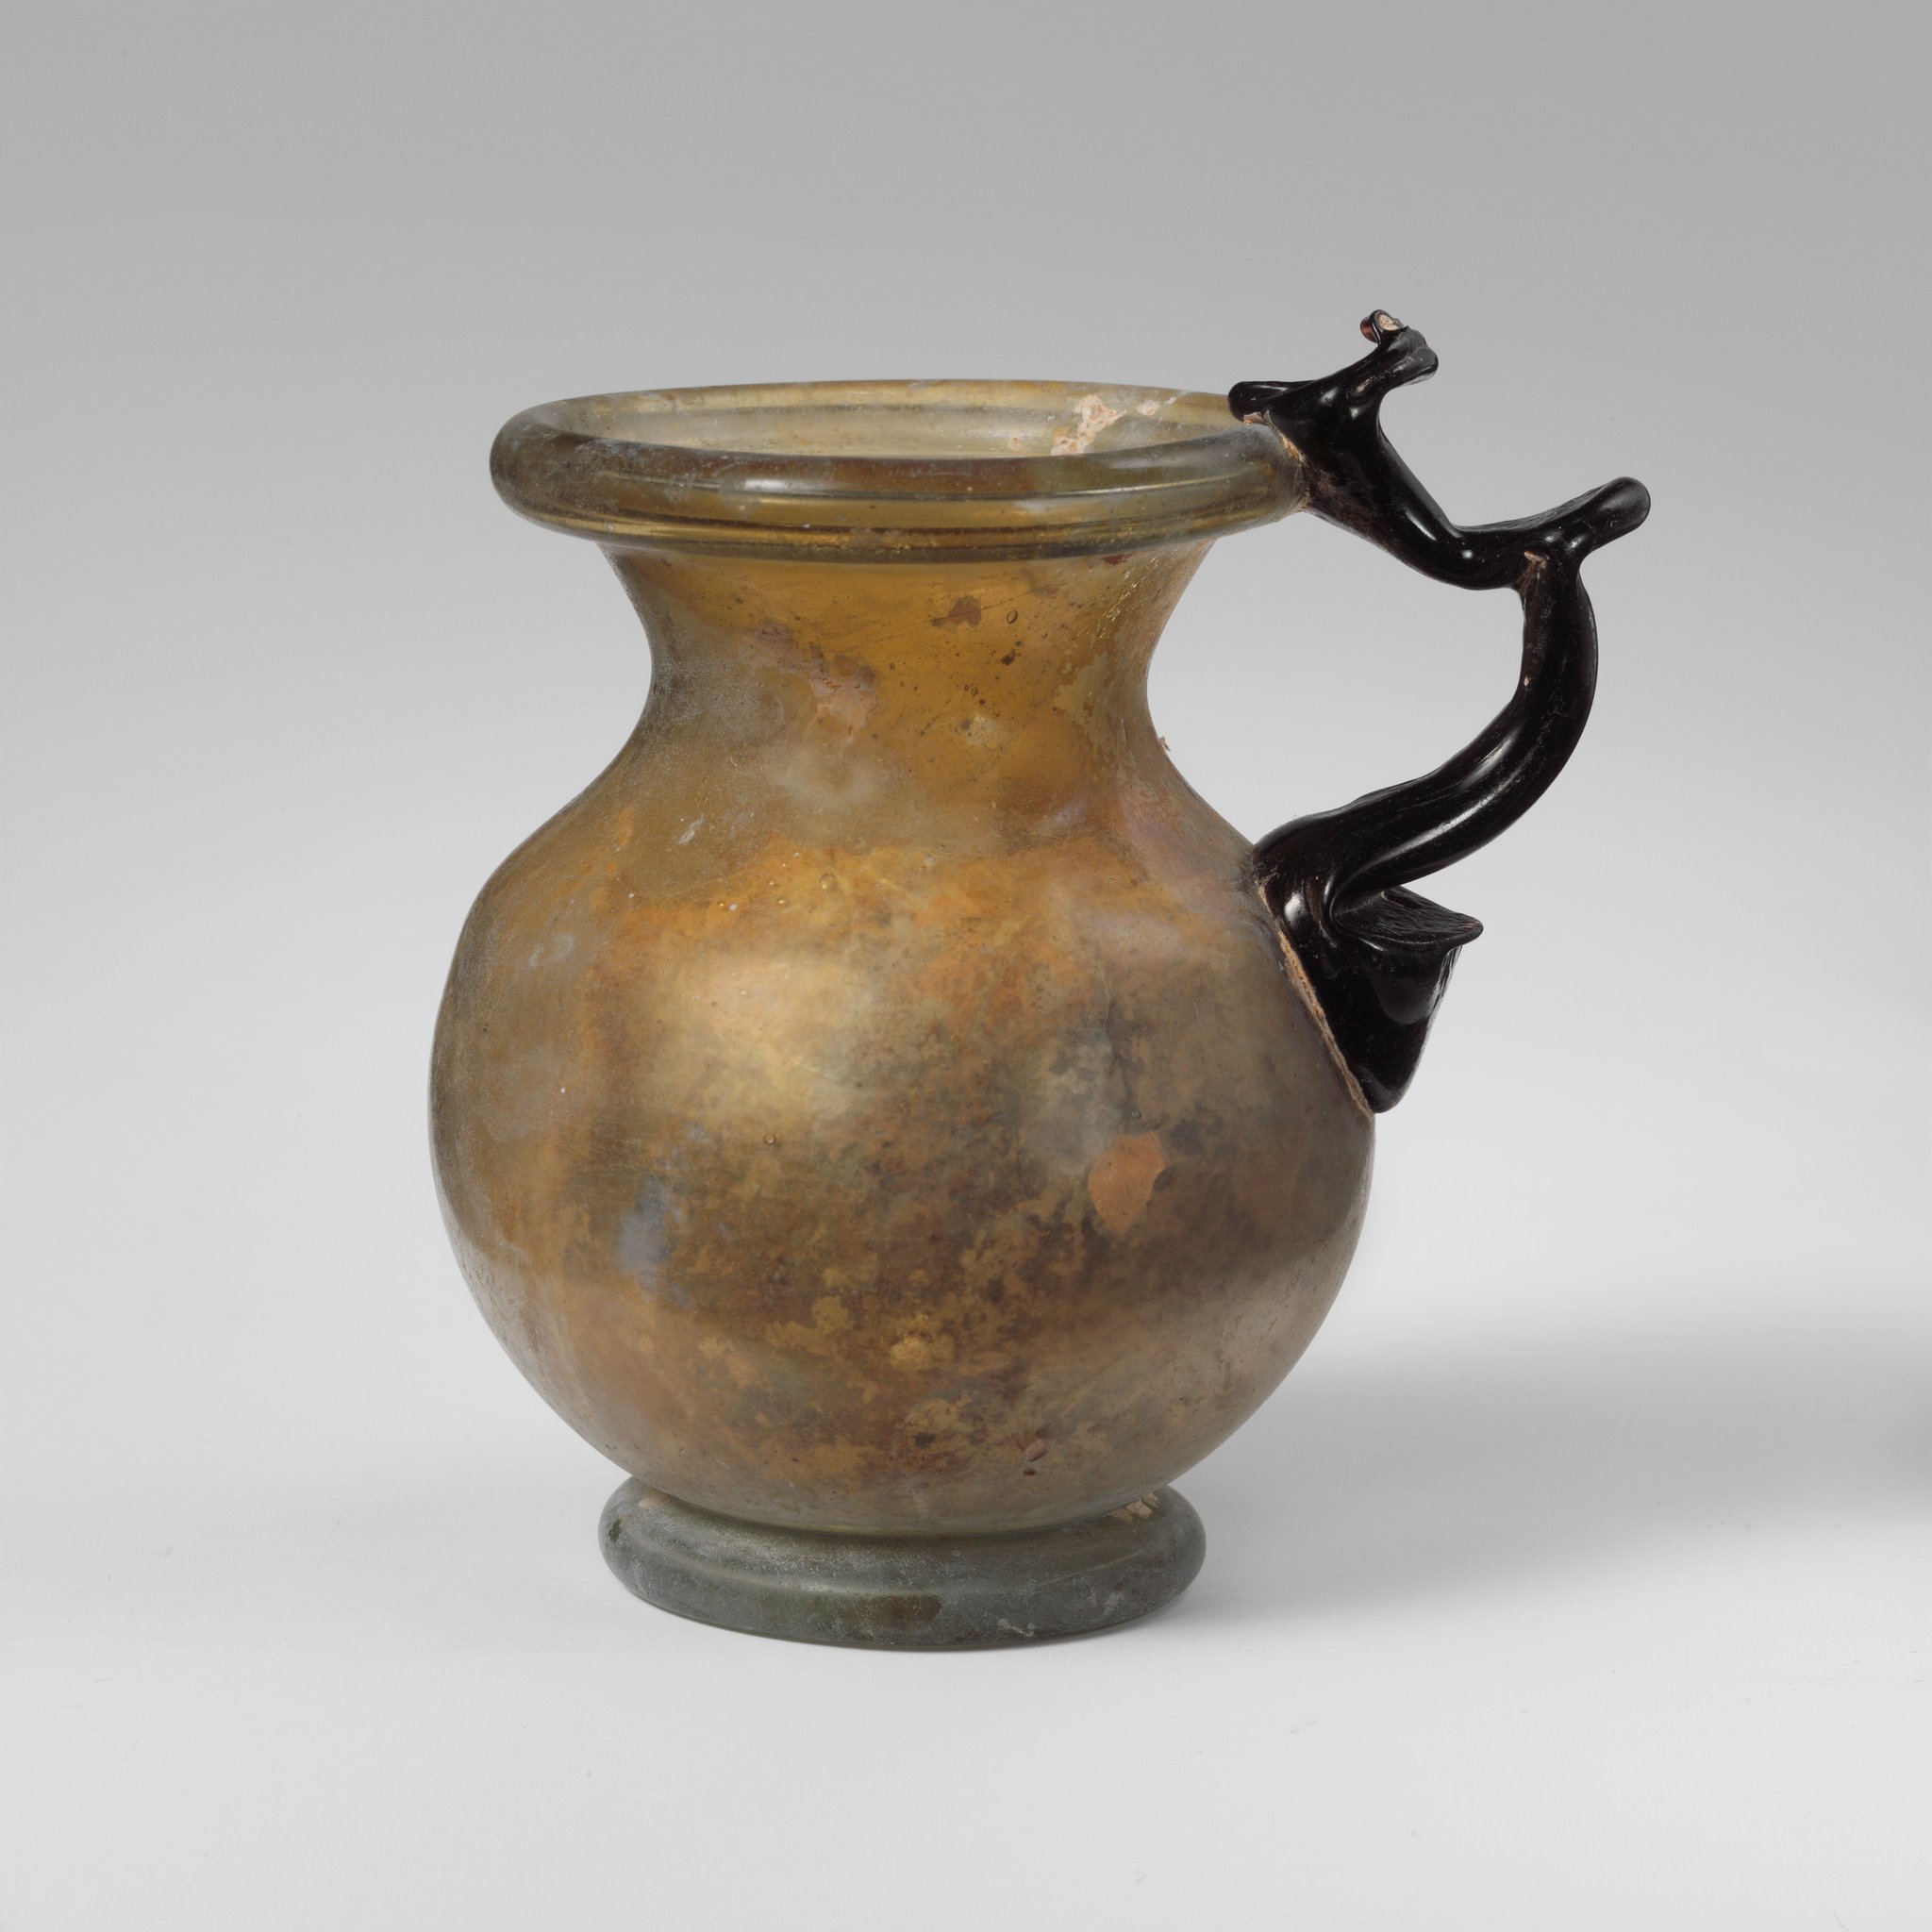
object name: jug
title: Glass jug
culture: roman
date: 301-500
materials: glass